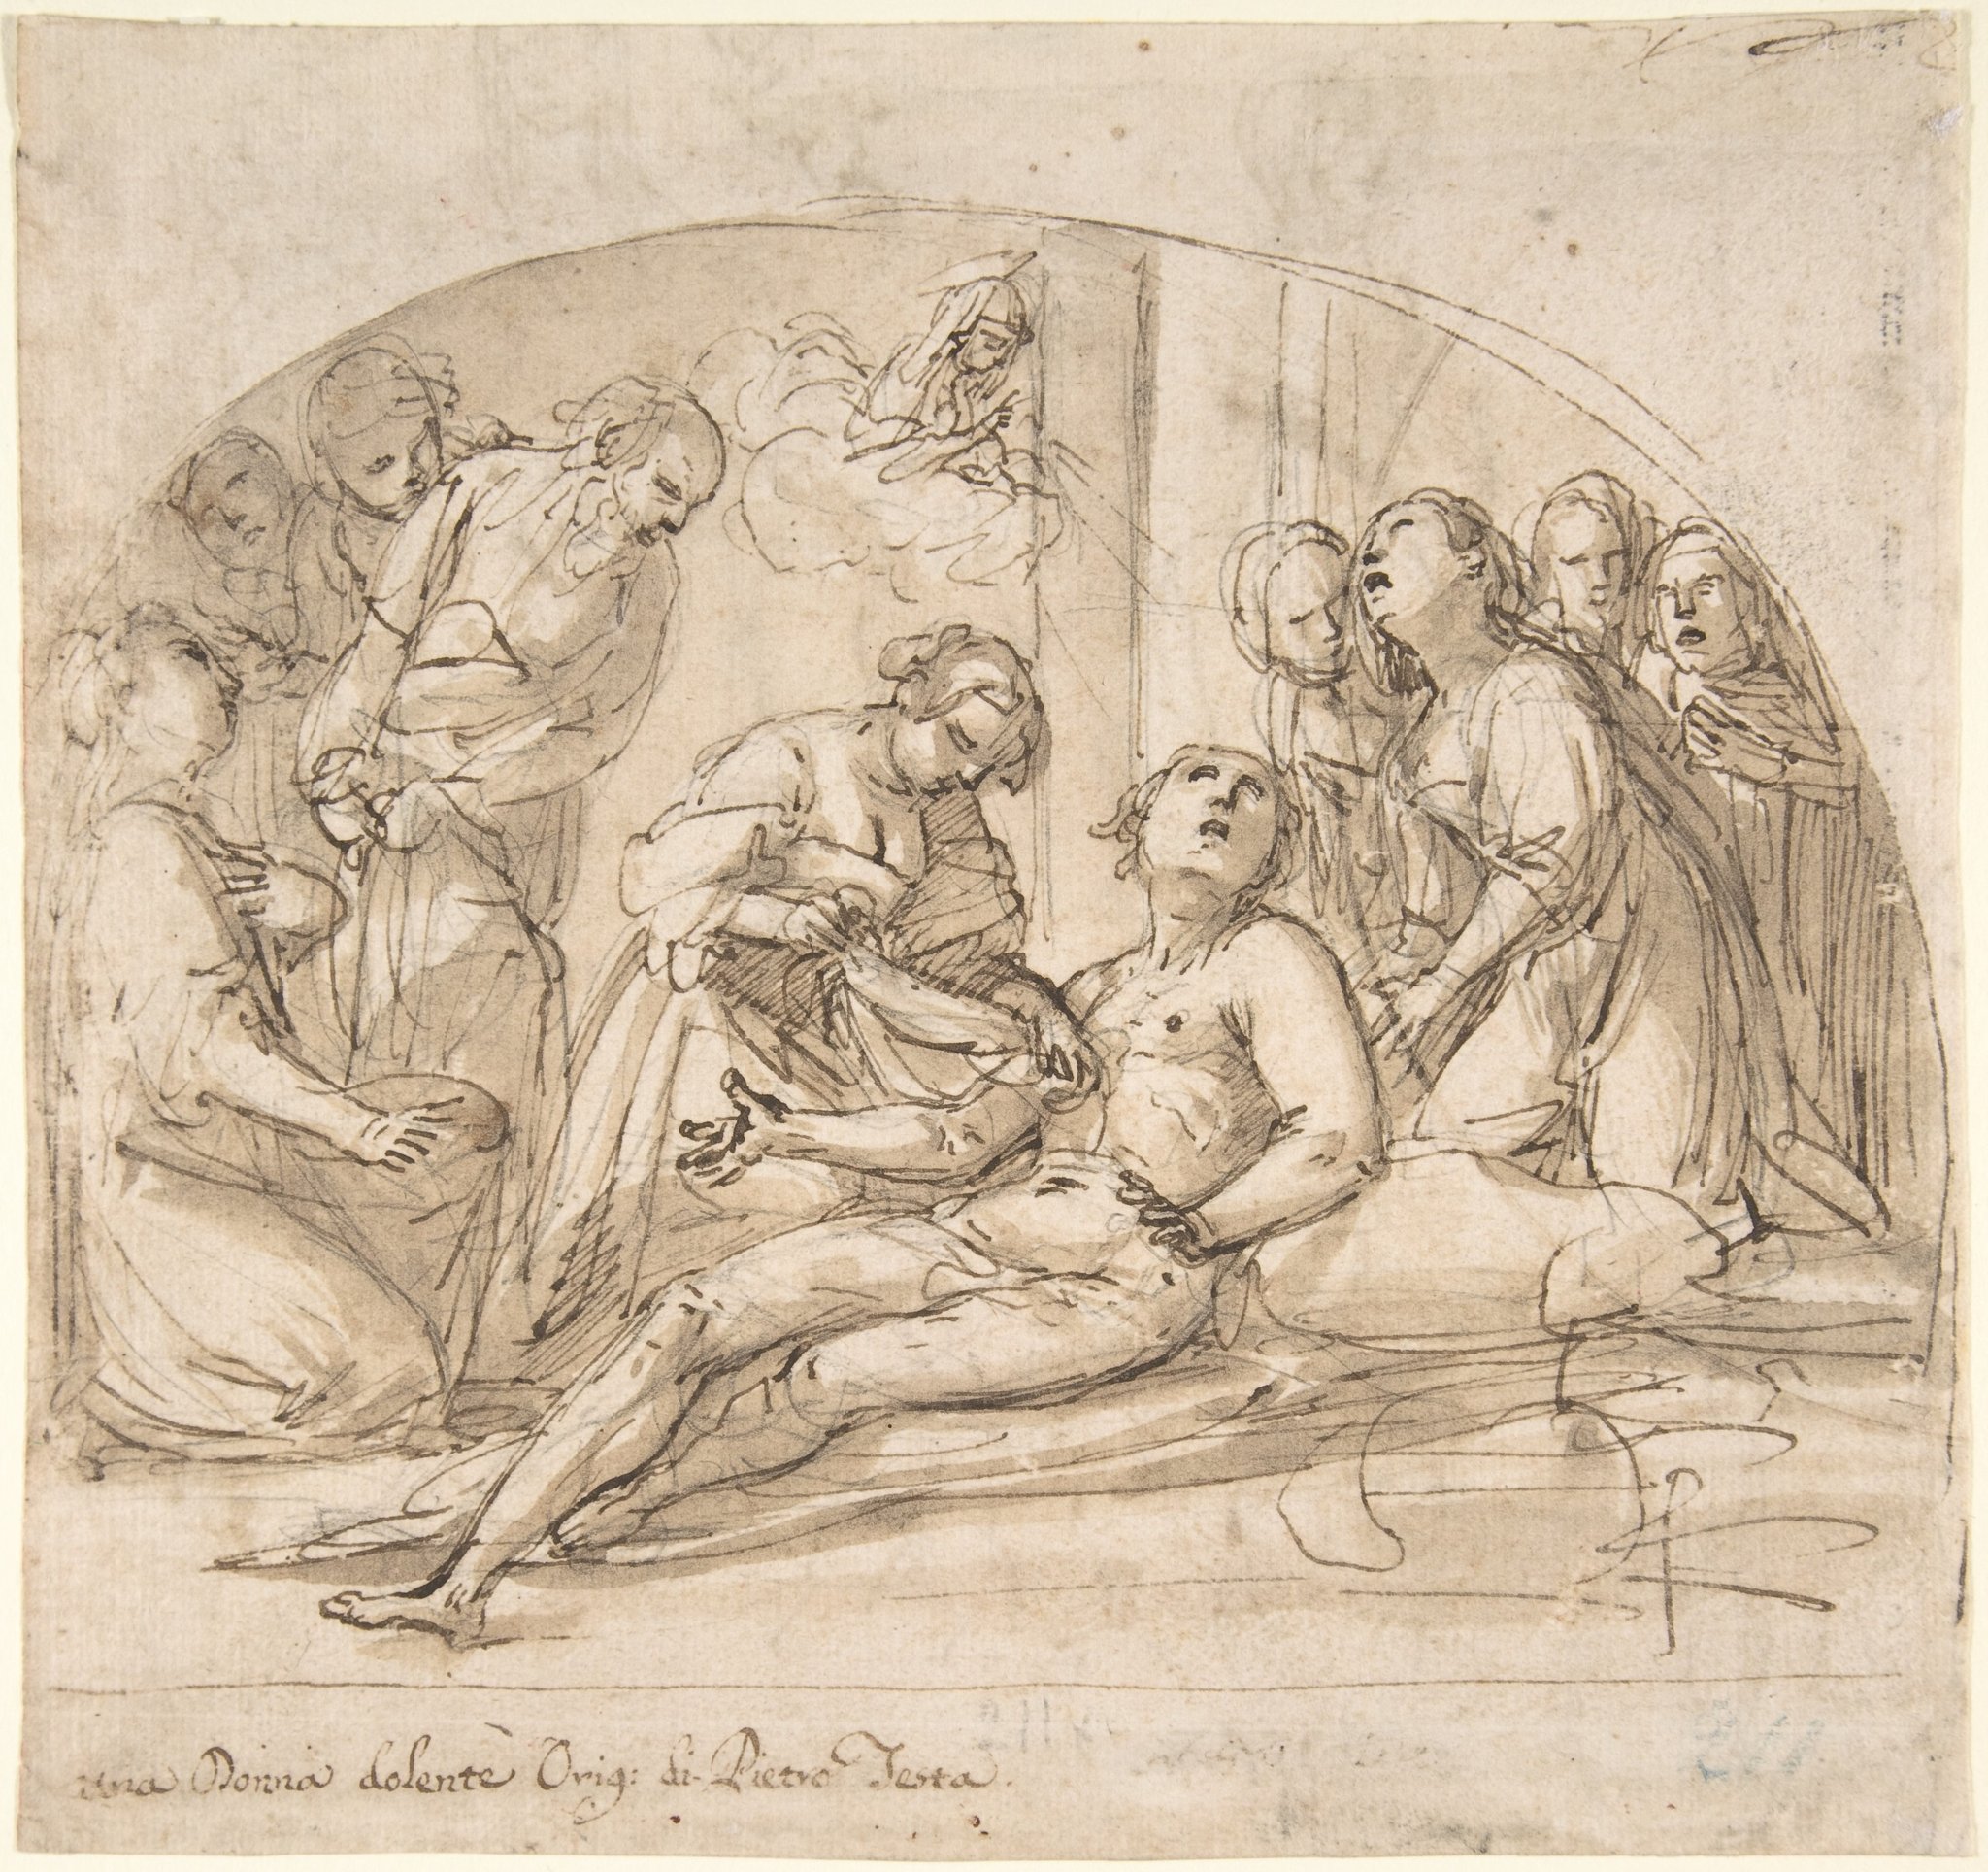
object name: drawing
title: The Emperor Constantine Copronymous Burned by an Invisible Fire (recto); Studies of Sibyls and Angles (verso)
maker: giovanni baglione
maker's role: artist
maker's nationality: italian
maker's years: 1566-1643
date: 1599-1610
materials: chalk, ink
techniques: brush, pen, wash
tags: suffering,men,women,angels